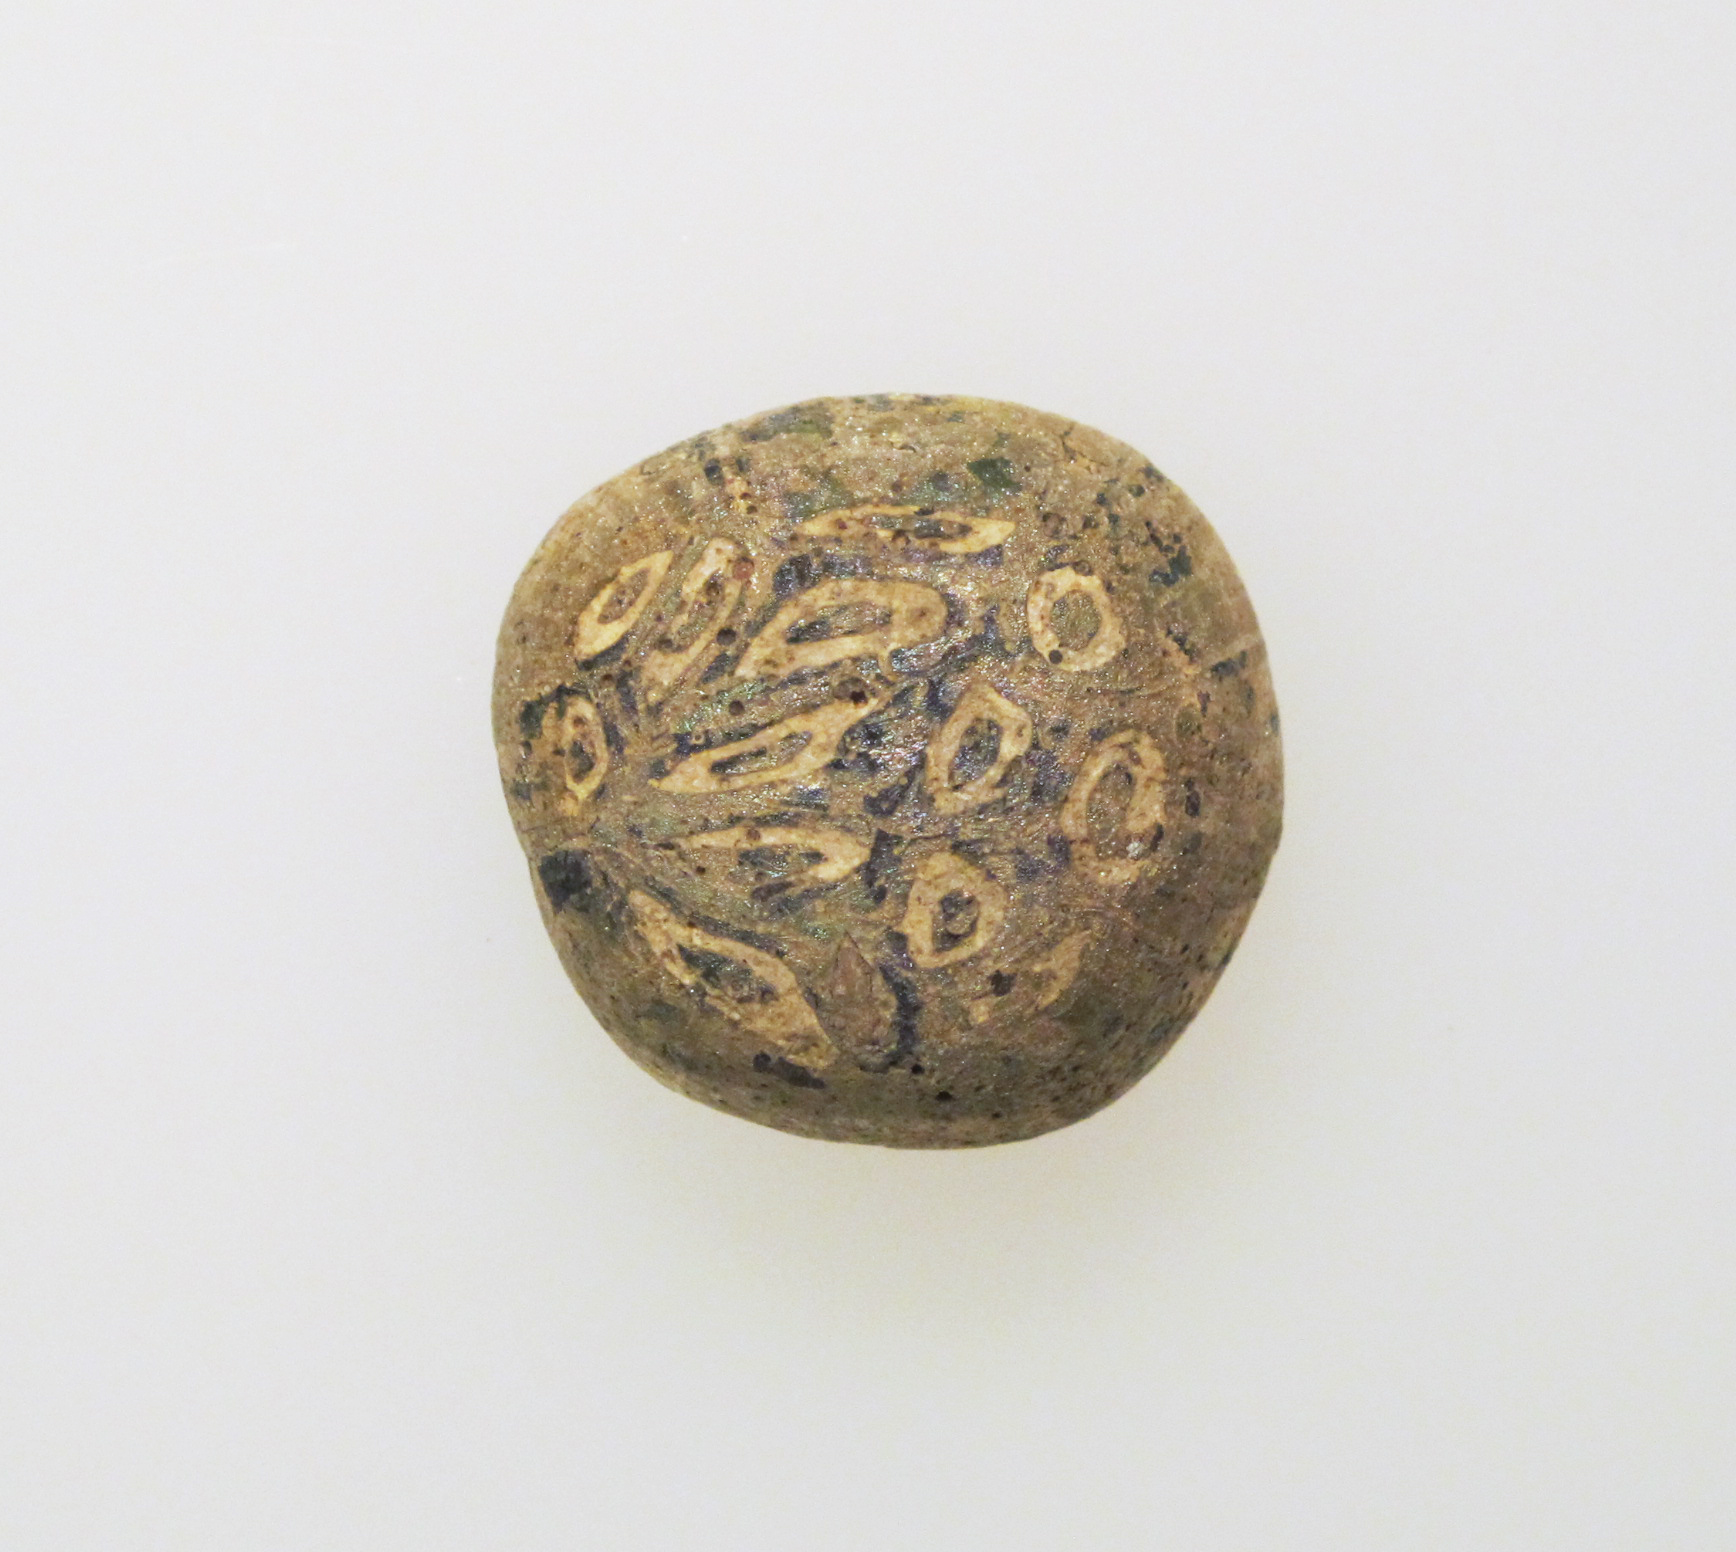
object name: pinhead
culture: roman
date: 670 BCE-330 CE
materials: glass